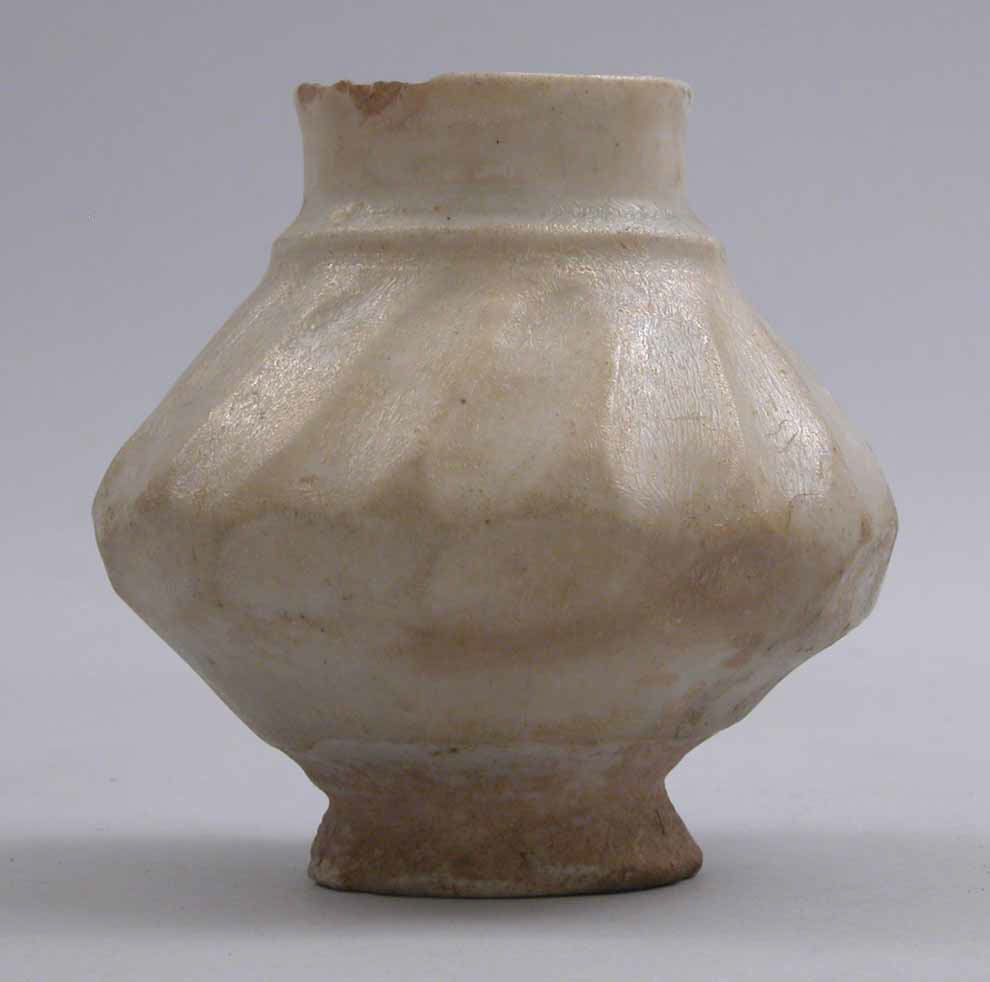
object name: jar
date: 1101-1200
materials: earthenware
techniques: glazing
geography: iran